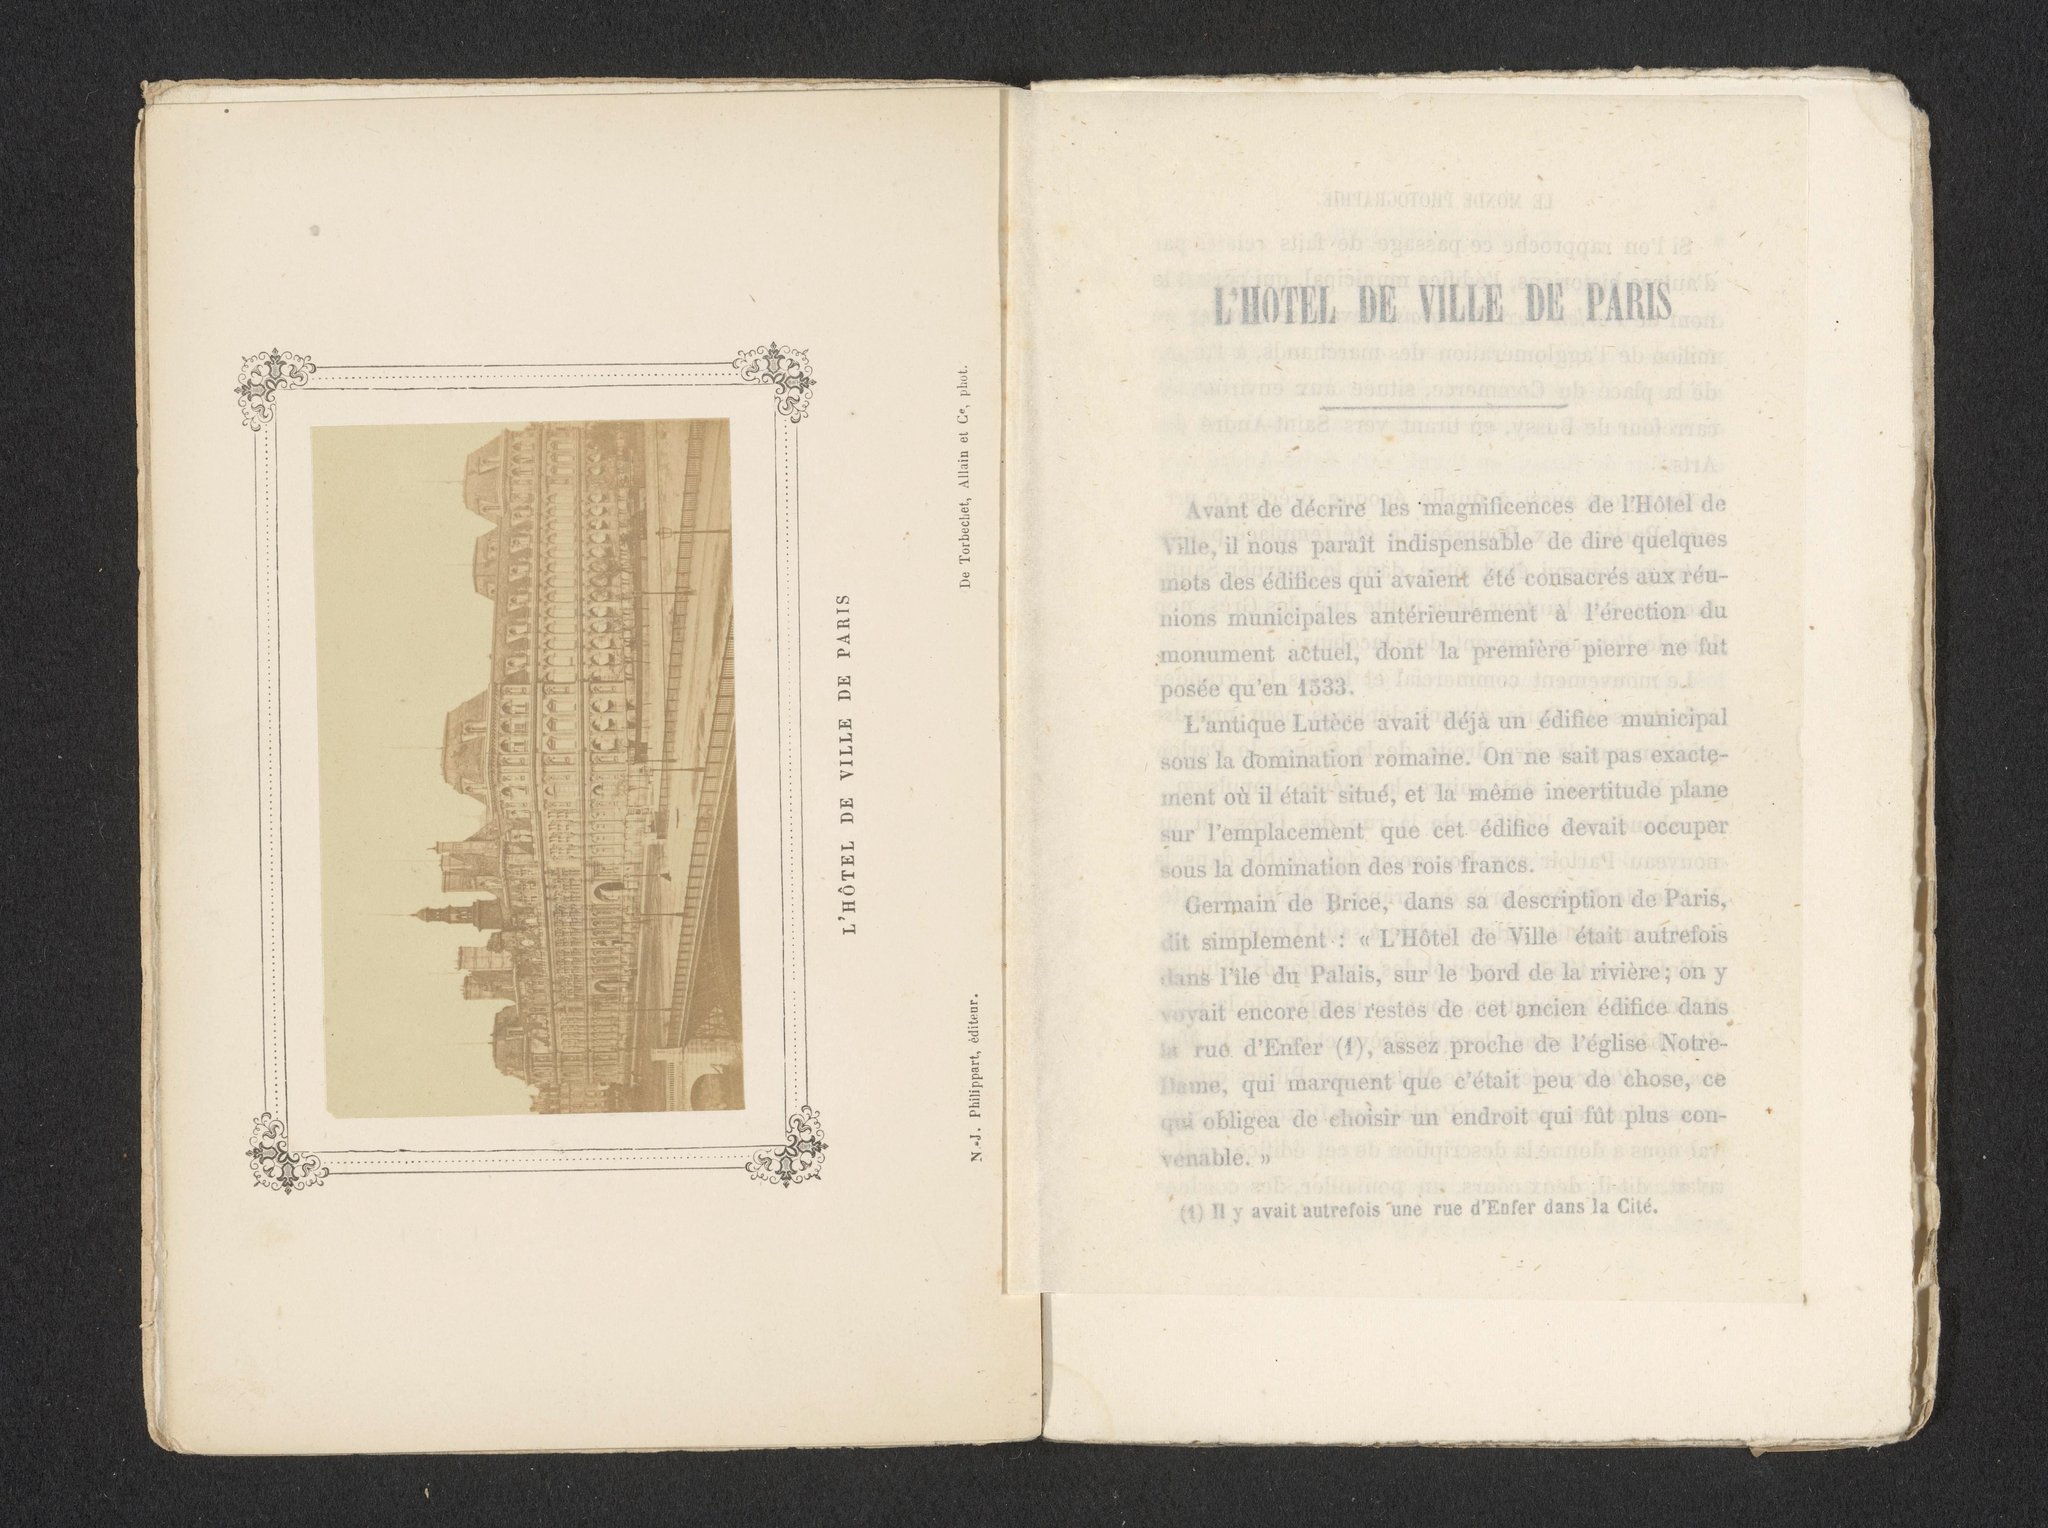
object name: page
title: Gezicht op het stadhuis van Parijs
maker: n.-j. philippart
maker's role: publisher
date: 1858-1863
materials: photographic support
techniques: albumen print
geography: paris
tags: townhall, façade (of house or building)